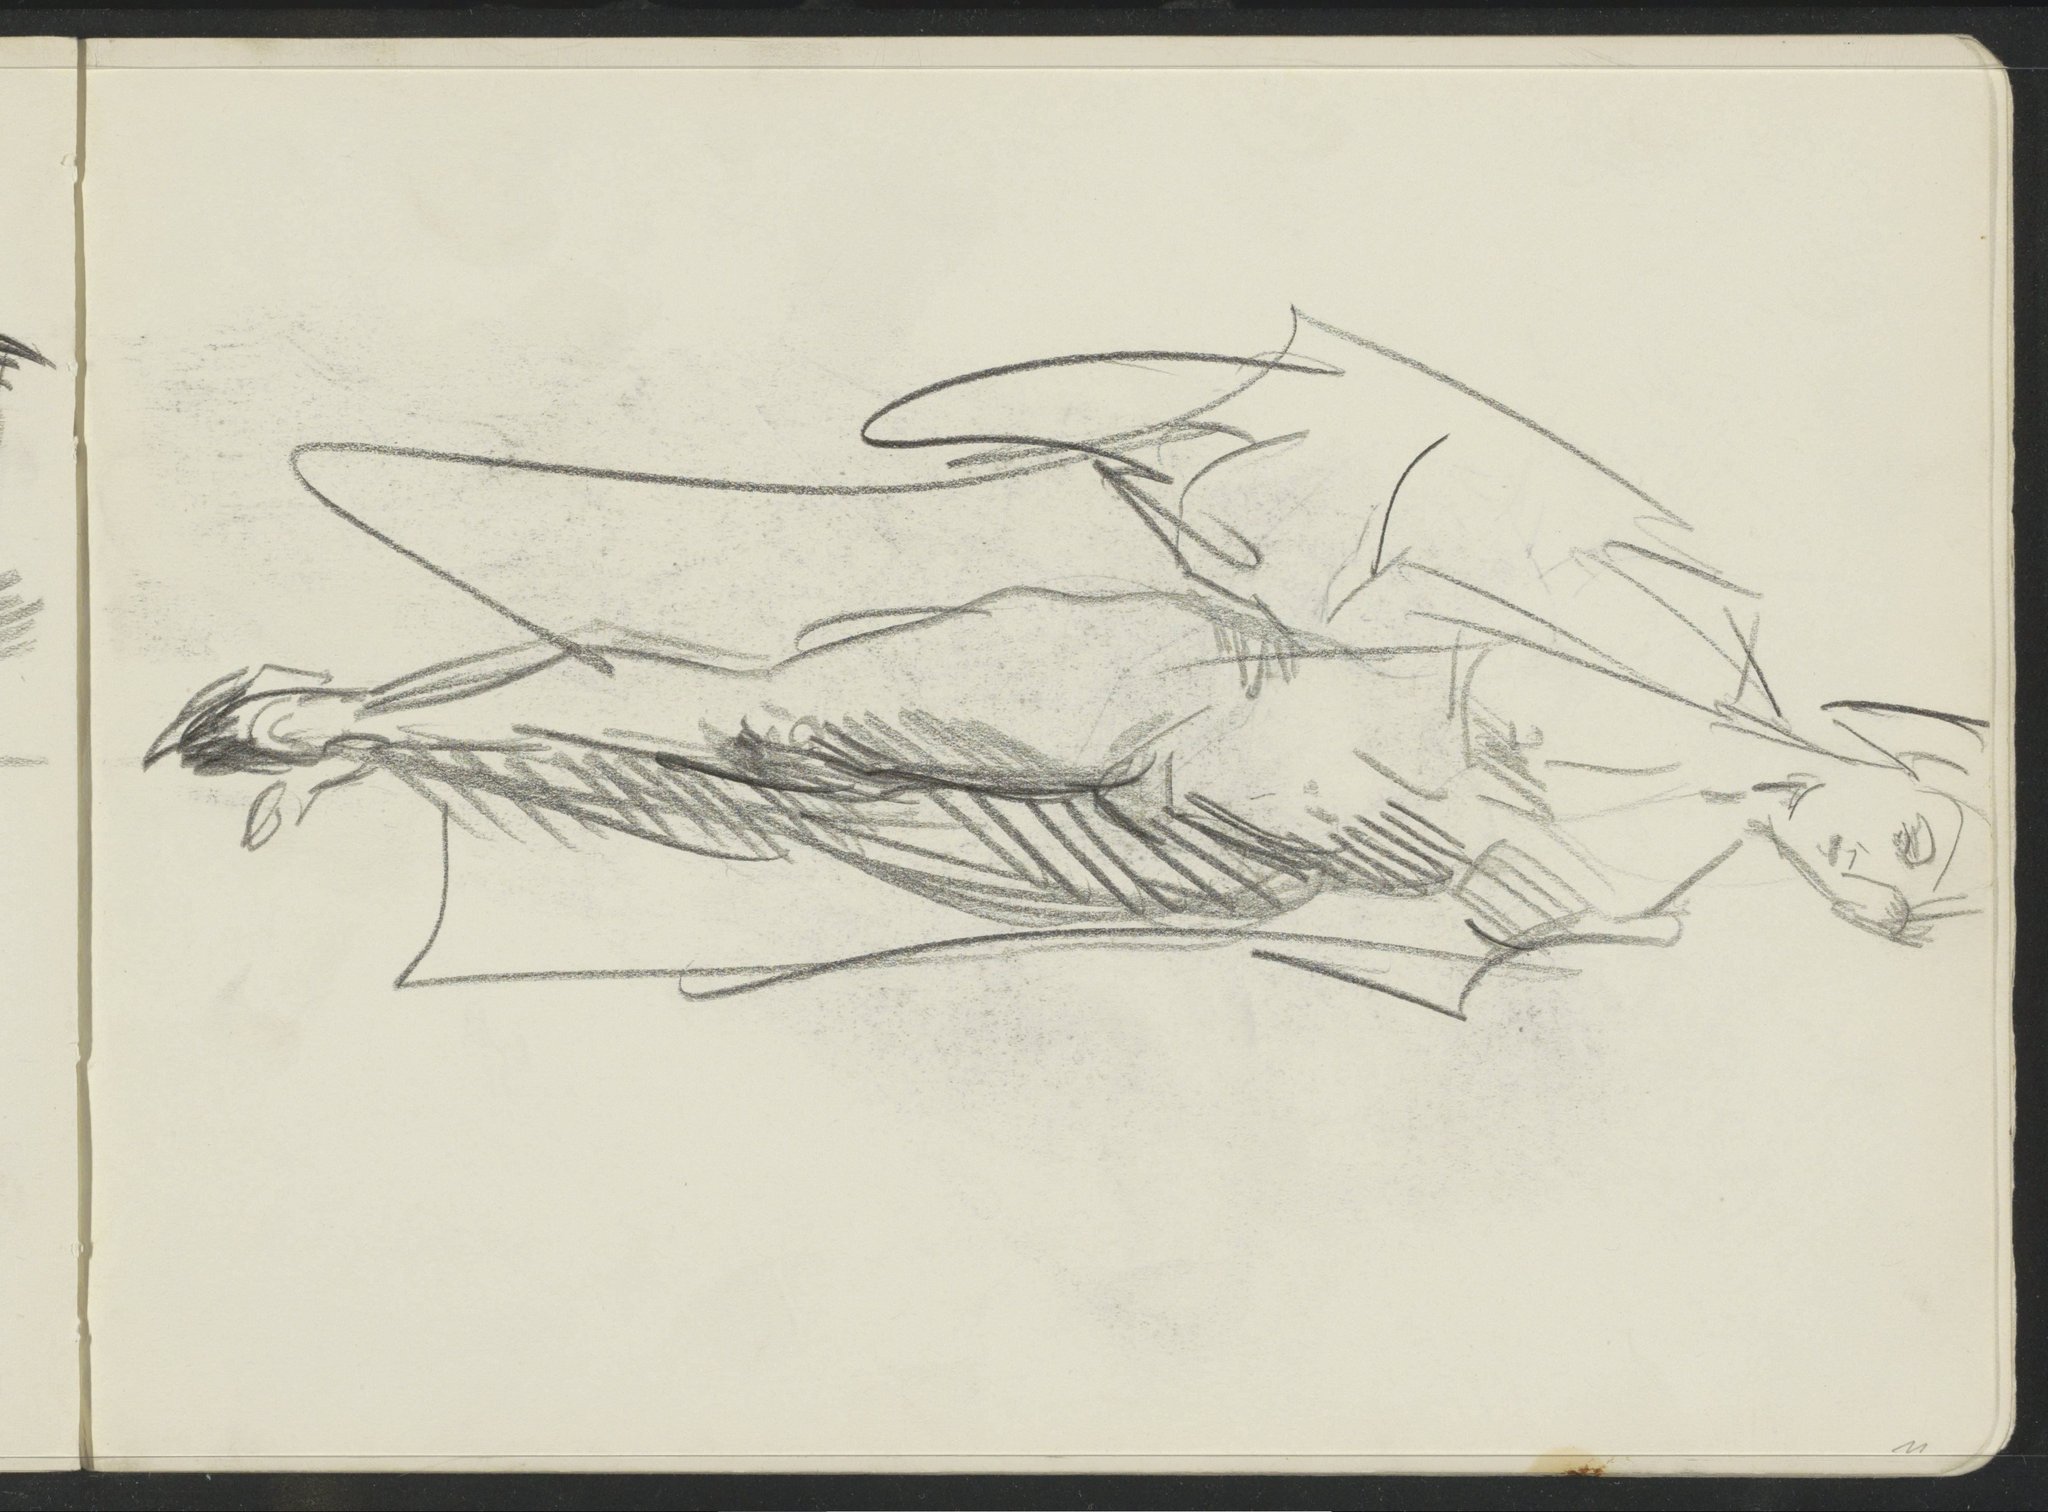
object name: sketchbook leaf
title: Staand vrouwelijk naakt met open mantel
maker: isaac israels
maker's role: draughtsman, painter, print maker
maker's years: 1865-1934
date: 1915-1934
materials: paper, pencil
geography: the hague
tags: coat (+ women's clothes), standing figure - aa - female human figure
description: Blad 11 recto uit schetsboek XV met 22 bladen.